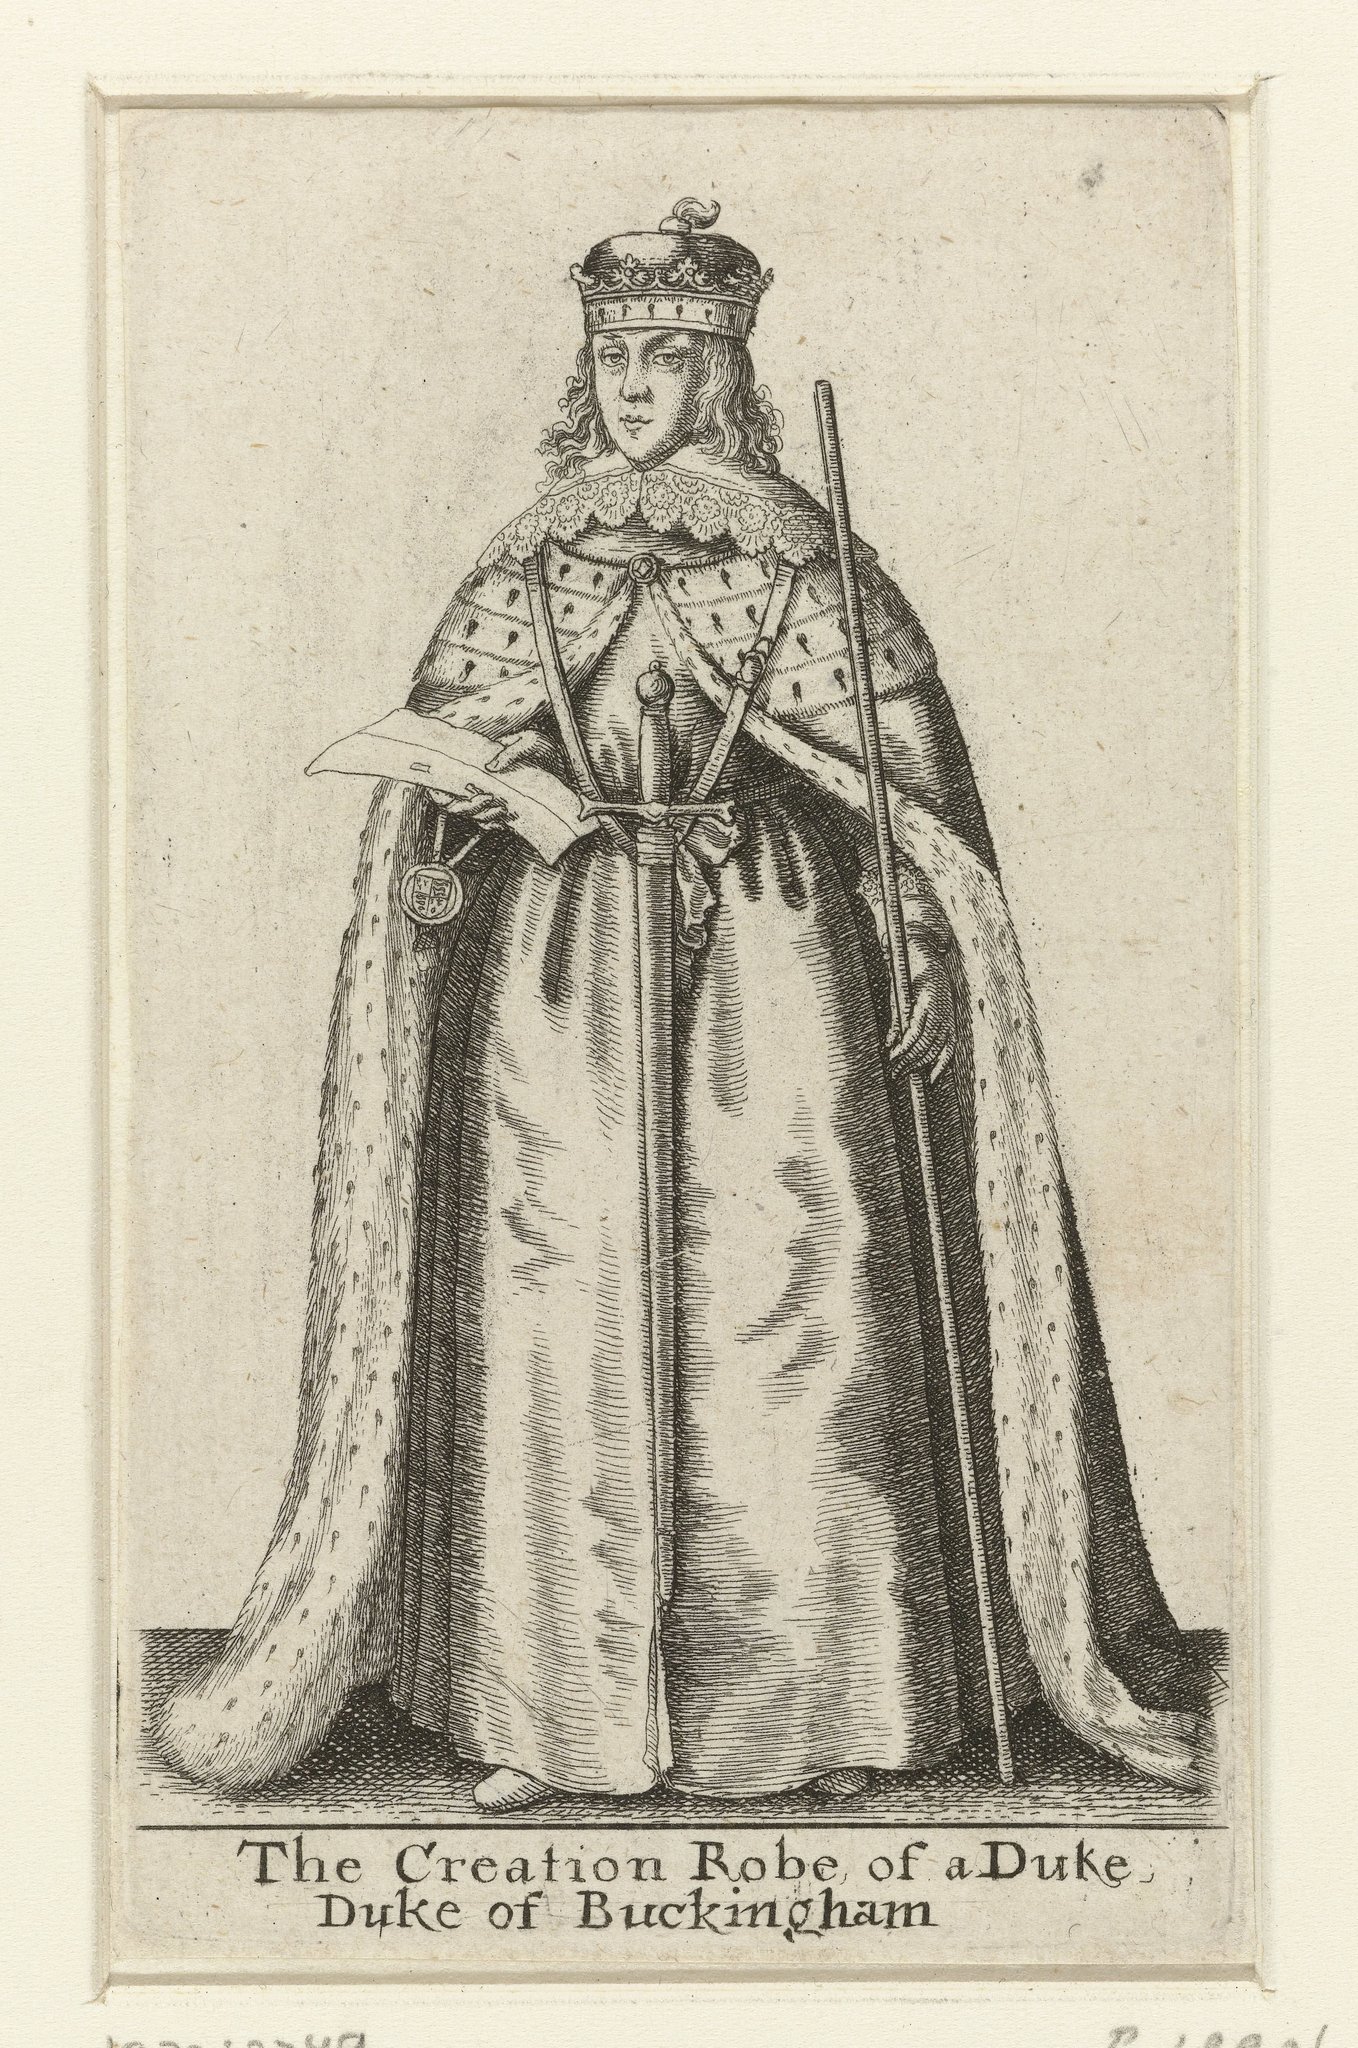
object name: print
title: Ceremoniële kledij van een Engelse hertog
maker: wenceslaus hollar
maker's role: draughtsman, print maker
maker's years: 1607-1677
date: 1617-1677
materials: paper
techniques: etching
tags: clothes for special purposes, nobility and patriciate; chivalry, knighthood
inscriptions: collector's mark: Lugt 654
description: De prent maakt deel uit van een negendelige serie met ceremoniële kledij van de Engelse adel. De prent (eerste staat) werd als onderdeel van bovengenoemde serie mogelijk door Thomas Jenner opgenomen onder de titel 'The Creation Robes of the Nobility in 9-Plates' in zijn 'A Catalogue of Severall Bookes', 1662. Hollar werkte naar ontwerpen uit Richard Glover's 'Nobilitas politica vel civilis', Londen, 1608.